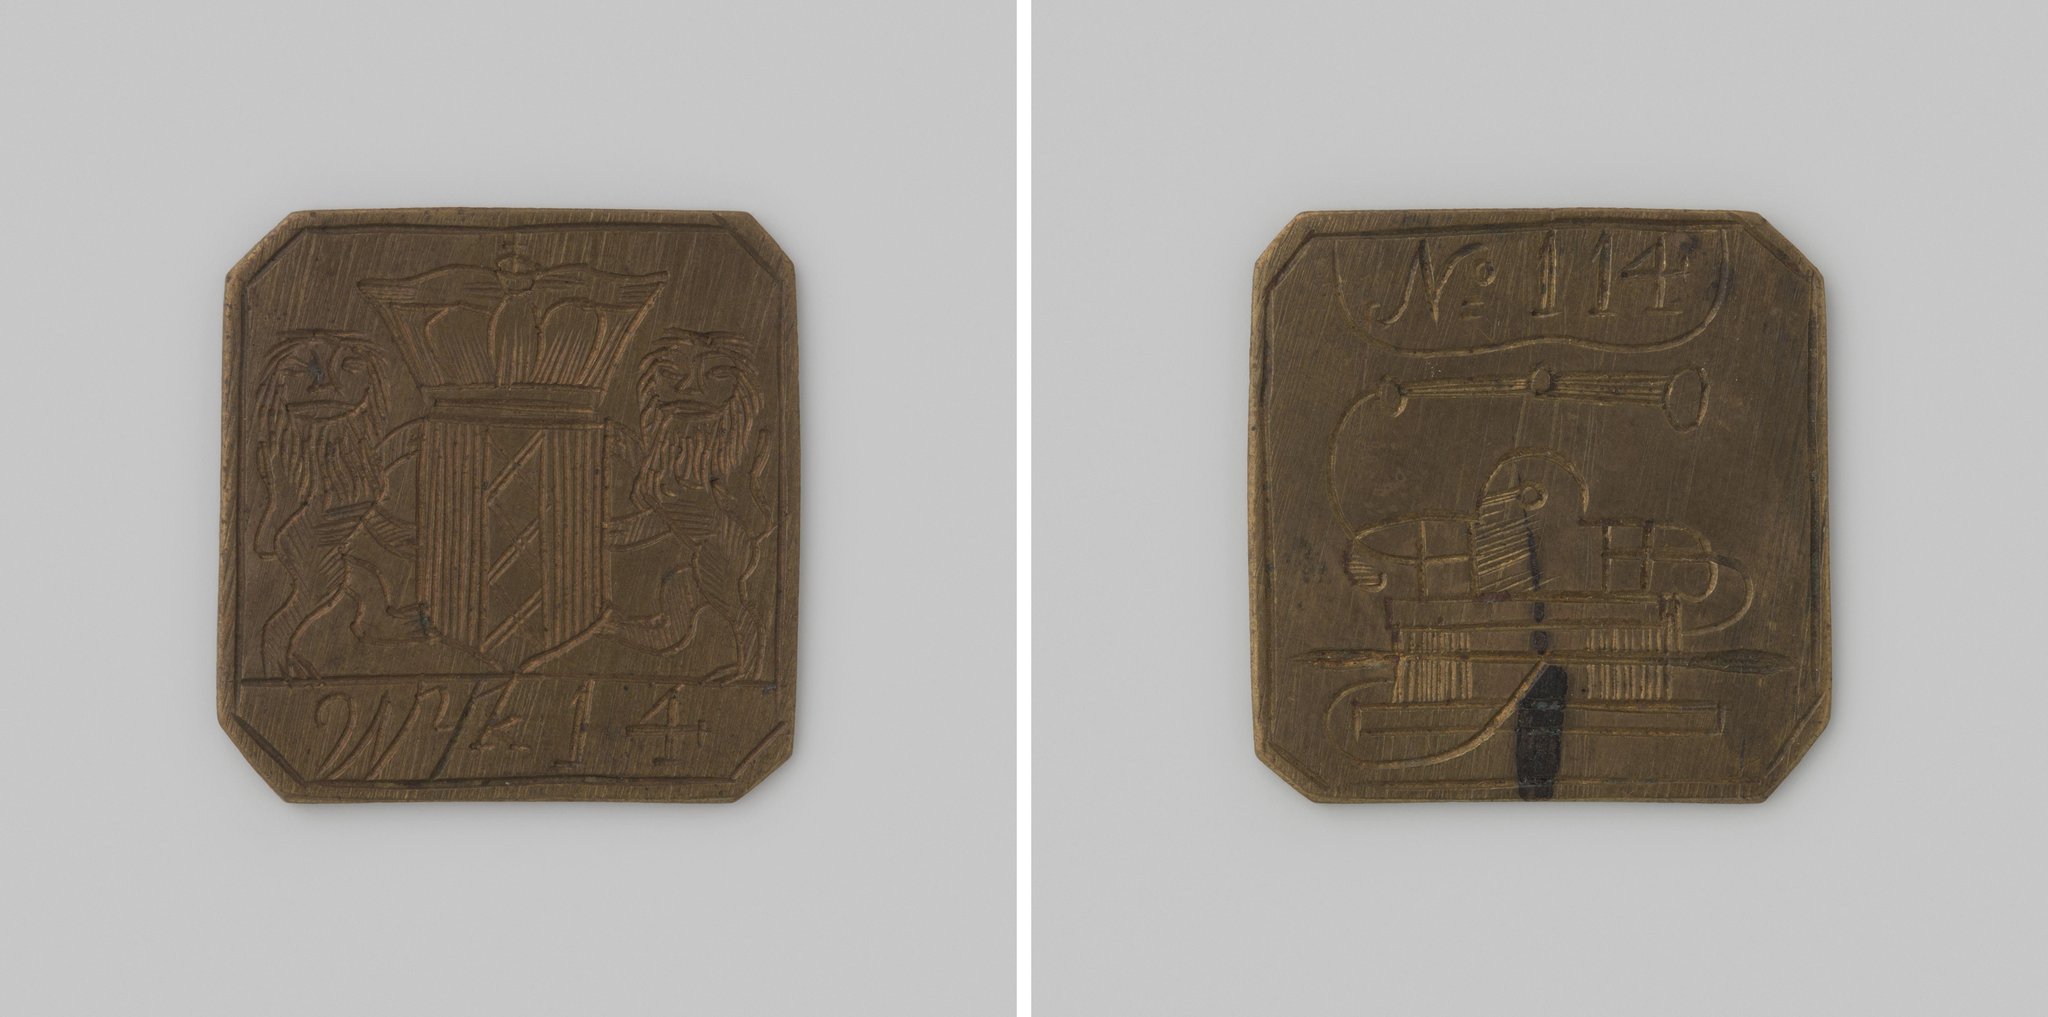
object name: medal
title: Amsterdam, brandspuitpenning van wijk 14, vierkant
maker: Anonymous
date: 1700-1799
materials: metal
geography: amsterdam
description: Vierkante metalen penning. Voorzijde: gekroond stadswapen met twee leeuwen als schildhouders, daaronder een letter en een cijfer van de wijk. Keerzijde: een brandspuit. Erboven gegraveerd een cijfer.